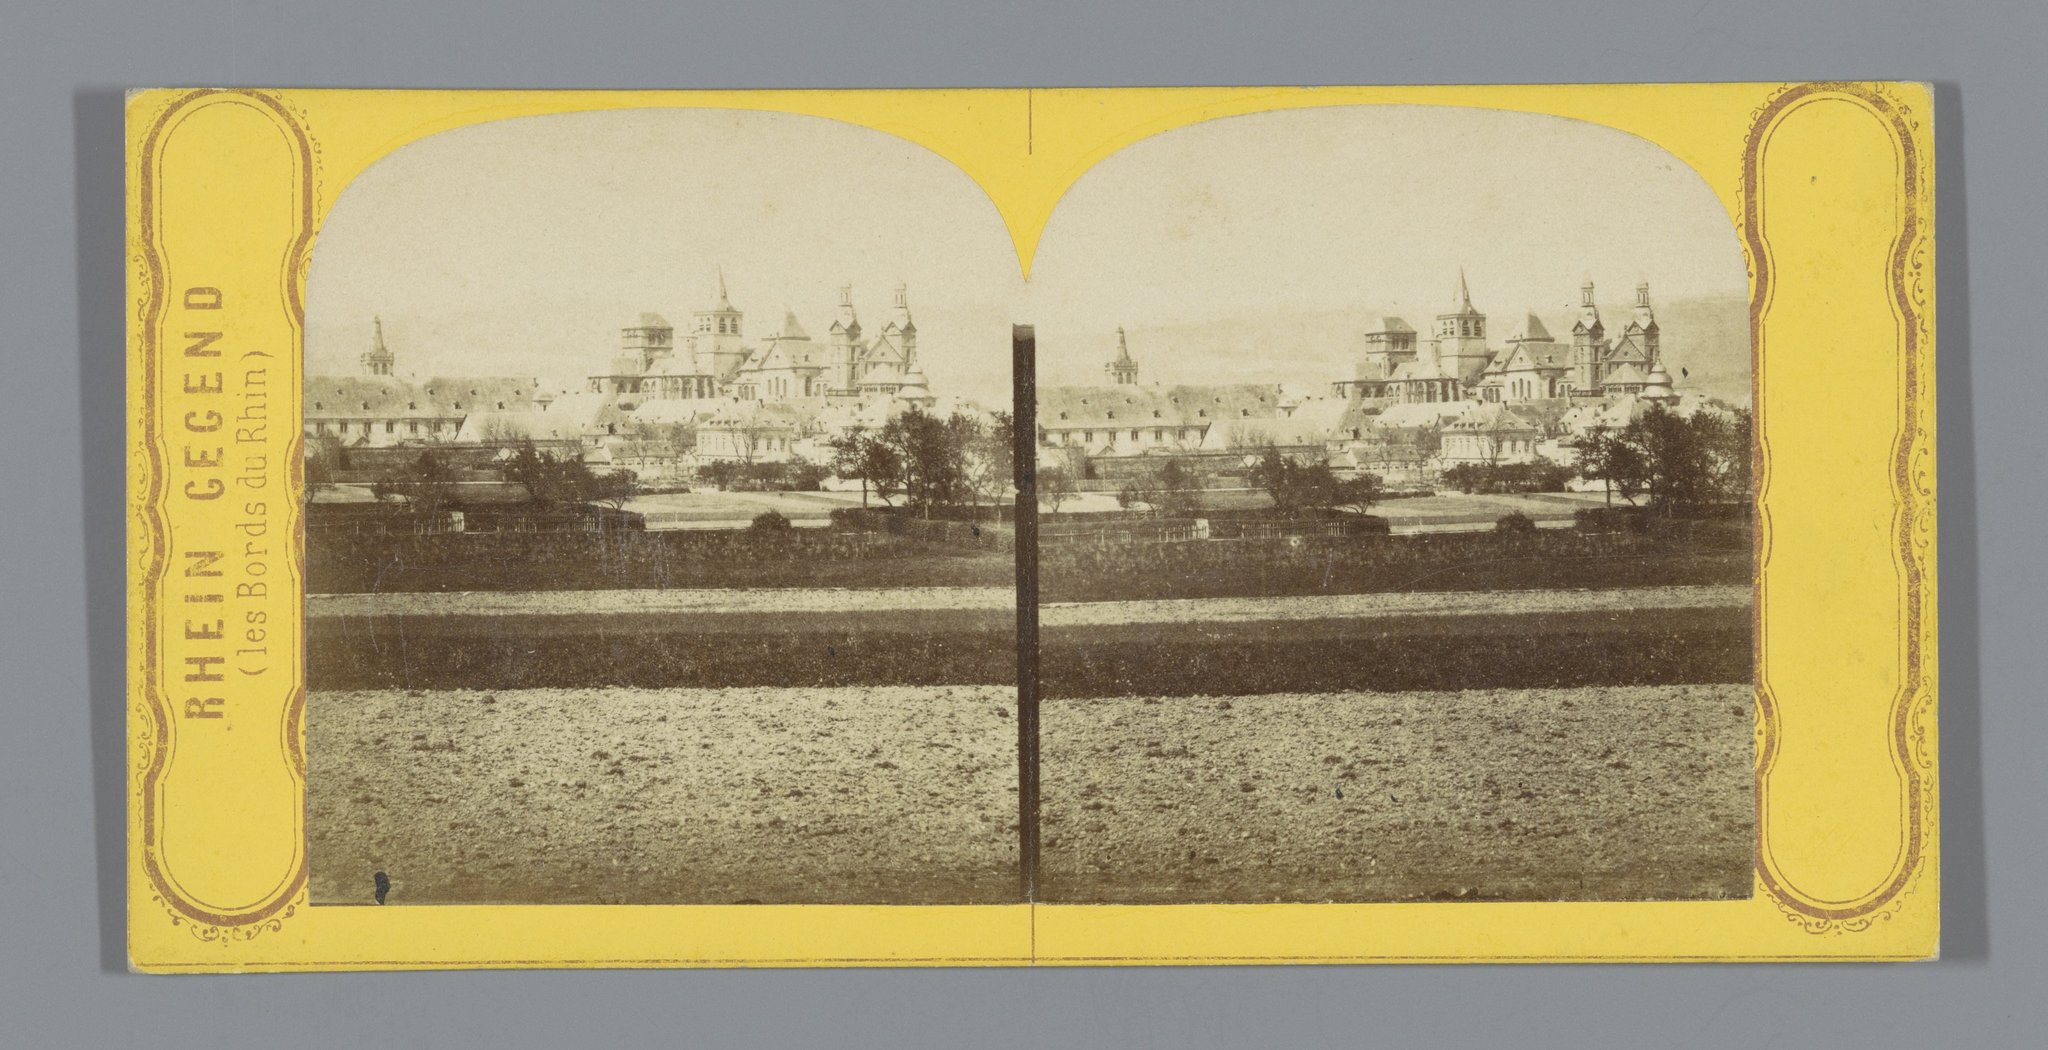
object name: stereograph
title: Rhein gegend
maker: Anonymous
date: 1860-1880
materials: cardboard, photographic support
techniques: albumen print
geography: trier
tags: city-view in general; 'veduta'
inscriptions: number: ‘No 1147’, inscription: ‘Treves’